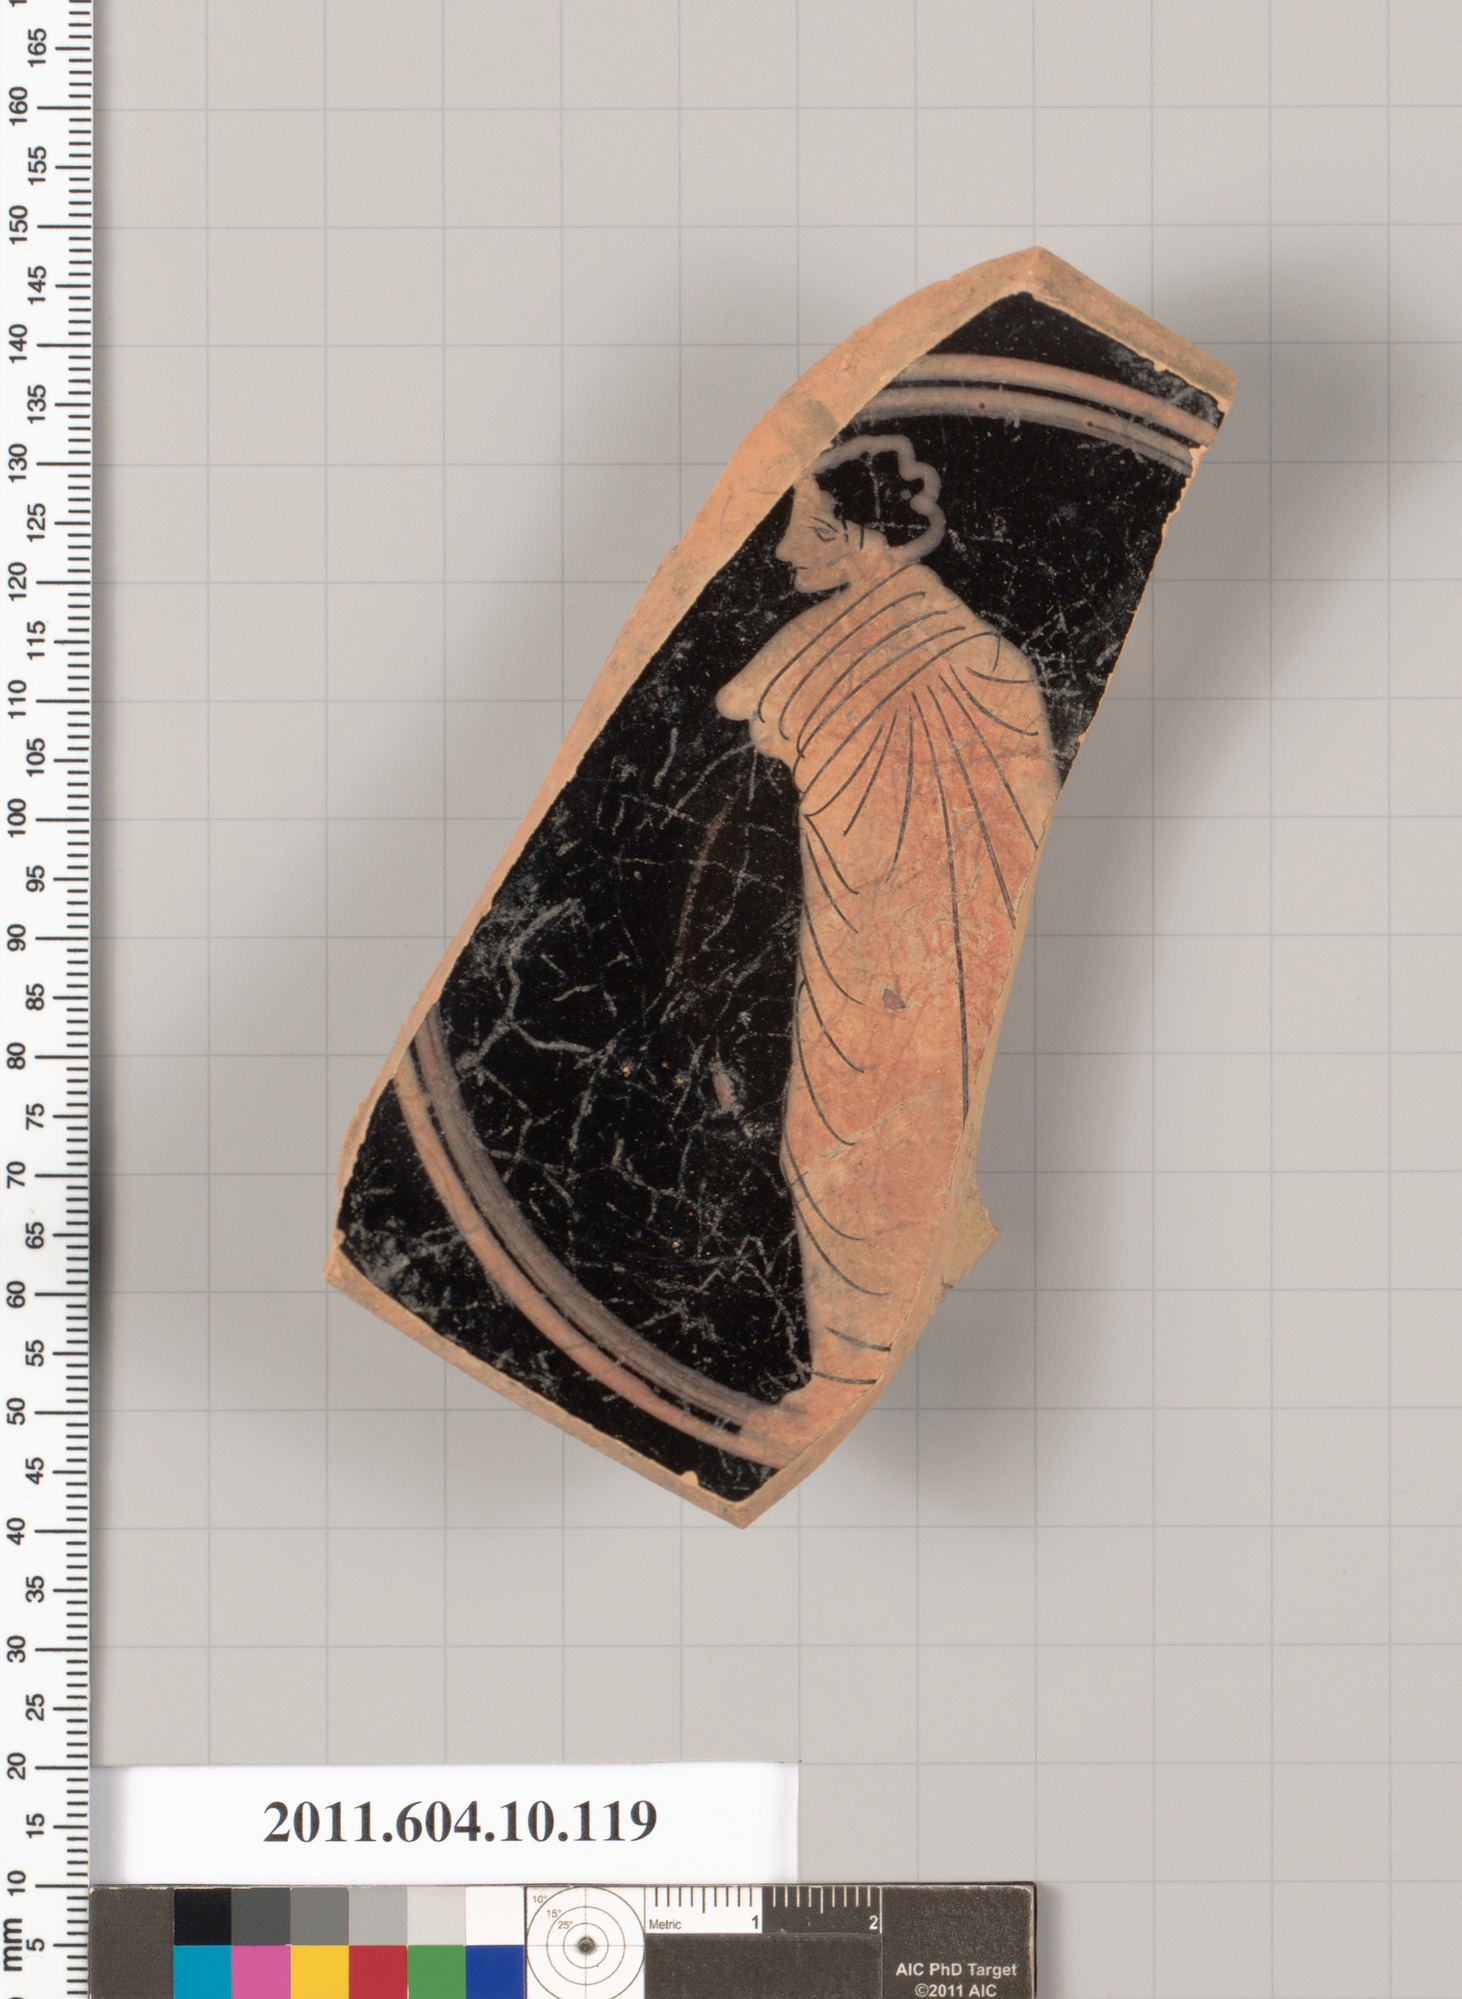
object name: kylix fragment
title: Terracotta fragment of a stemless kylix (drinking cup)?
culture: etruscan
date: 434-368 BCE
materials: terracotta